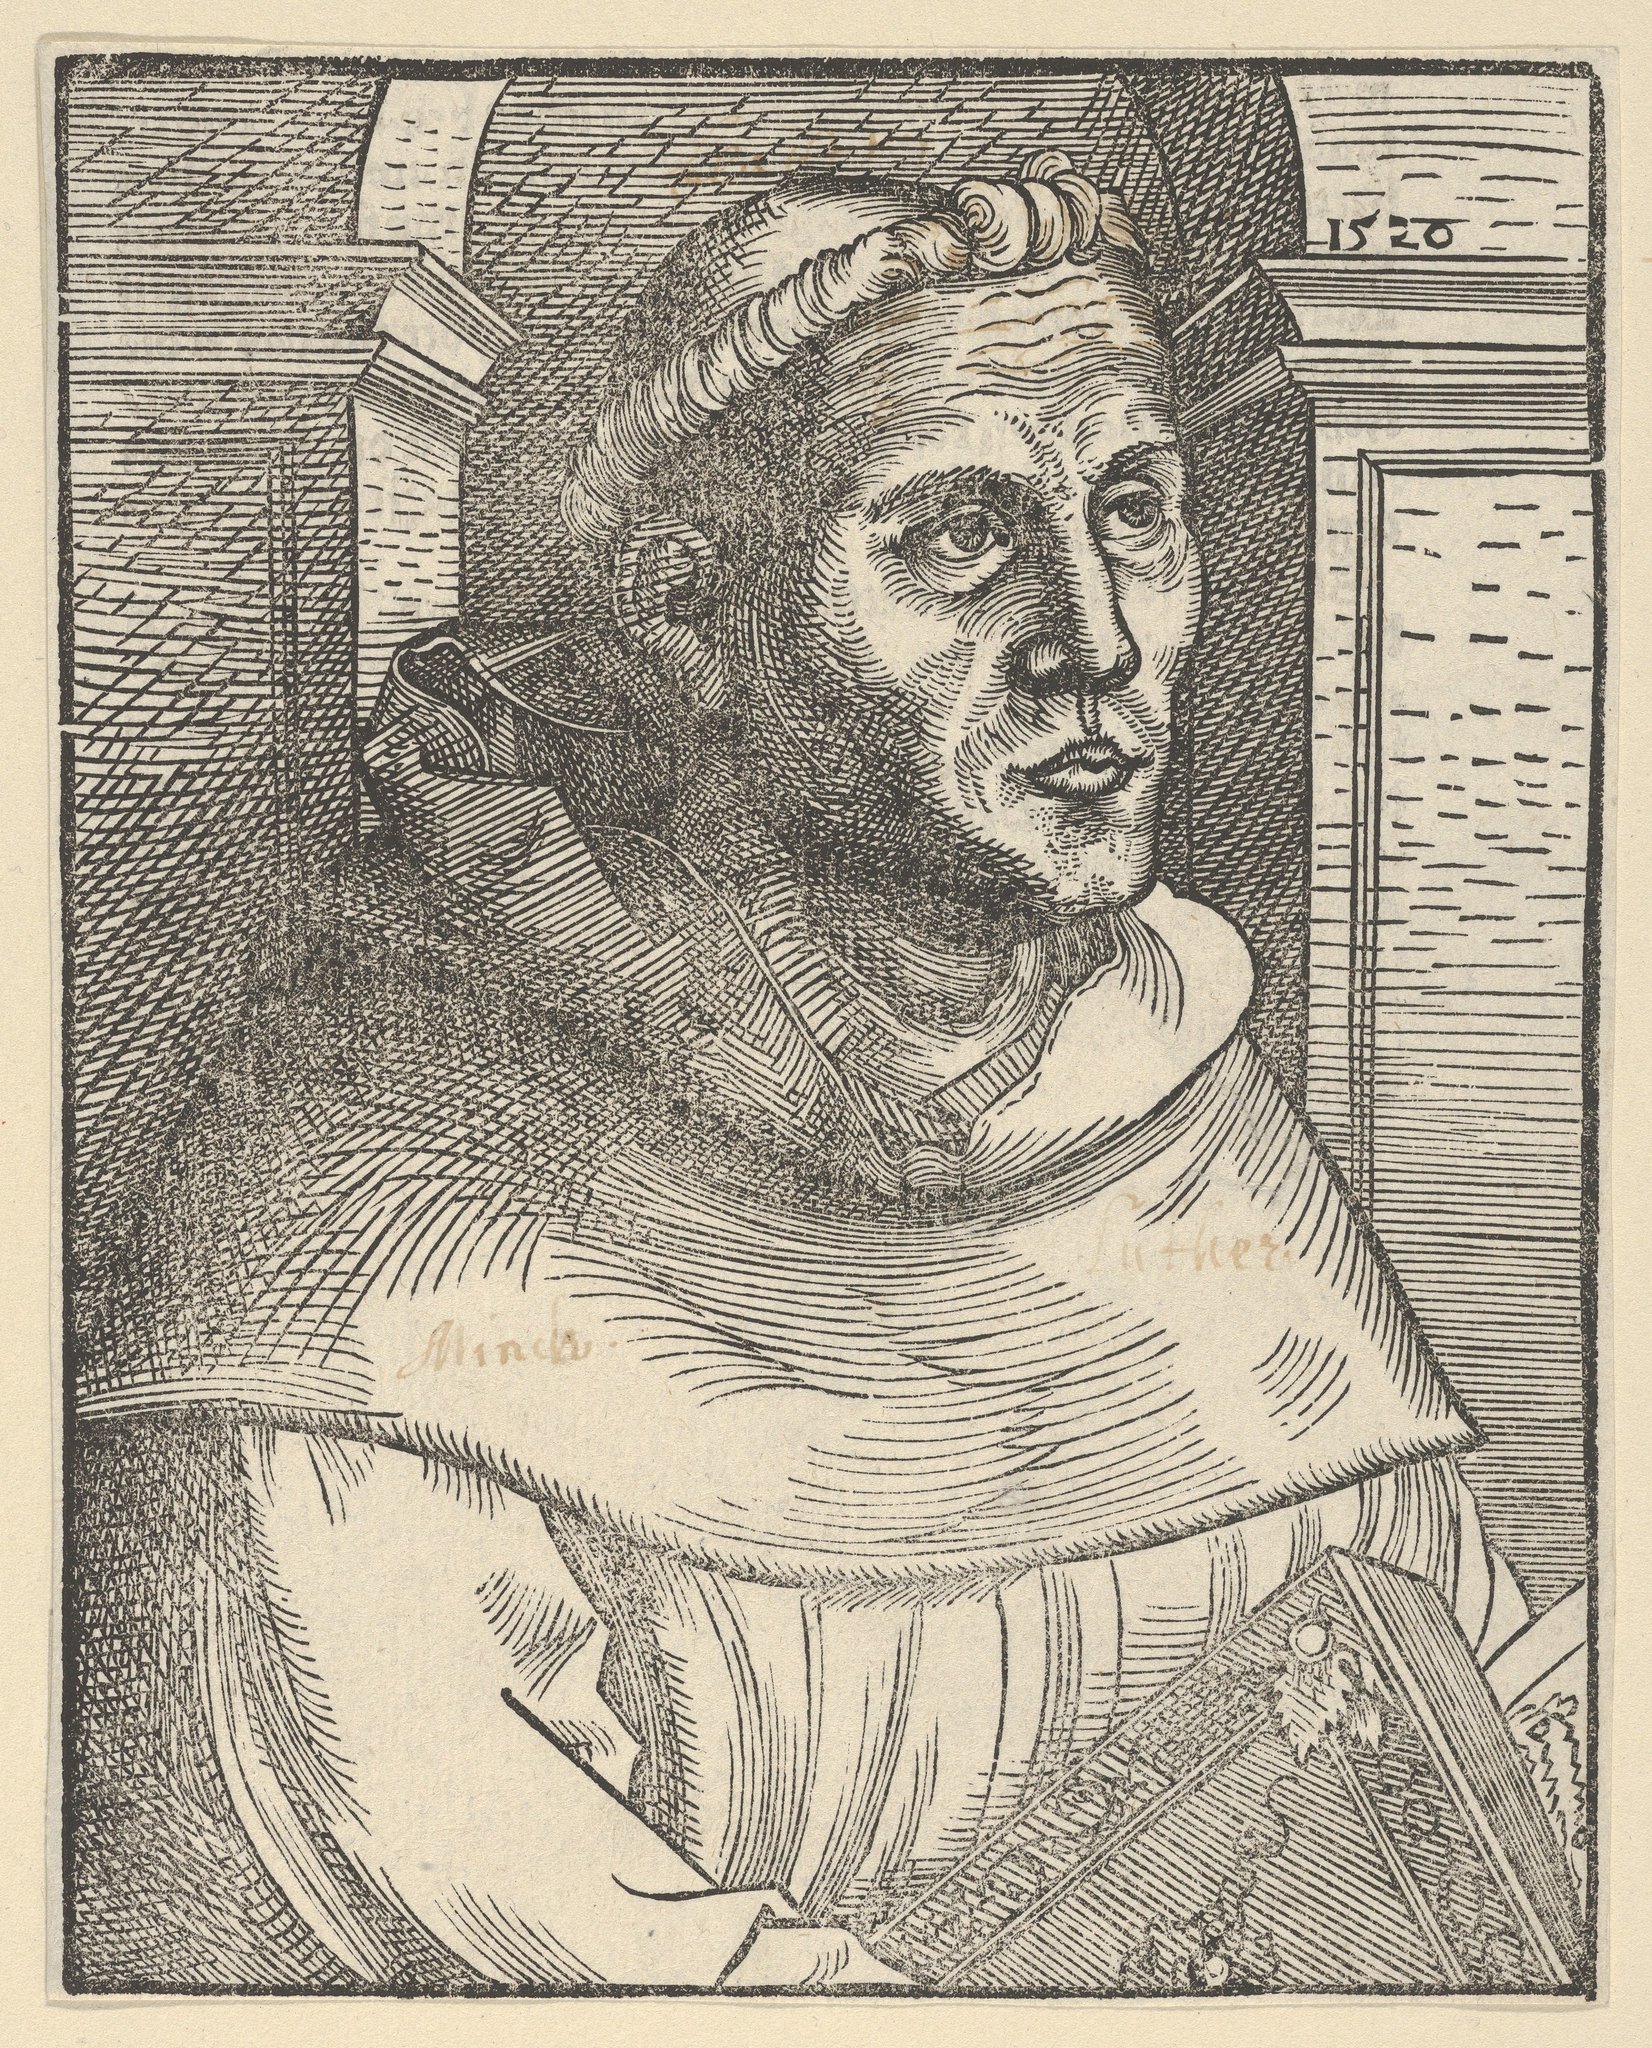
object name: print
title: Copy of Luther as an Augustinian Friar, Half Length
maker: anonymous, german, 16th century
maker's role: artist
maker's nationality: german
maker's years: 1500-1600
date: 1520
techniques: woodcut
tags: martin luther,men,portraits